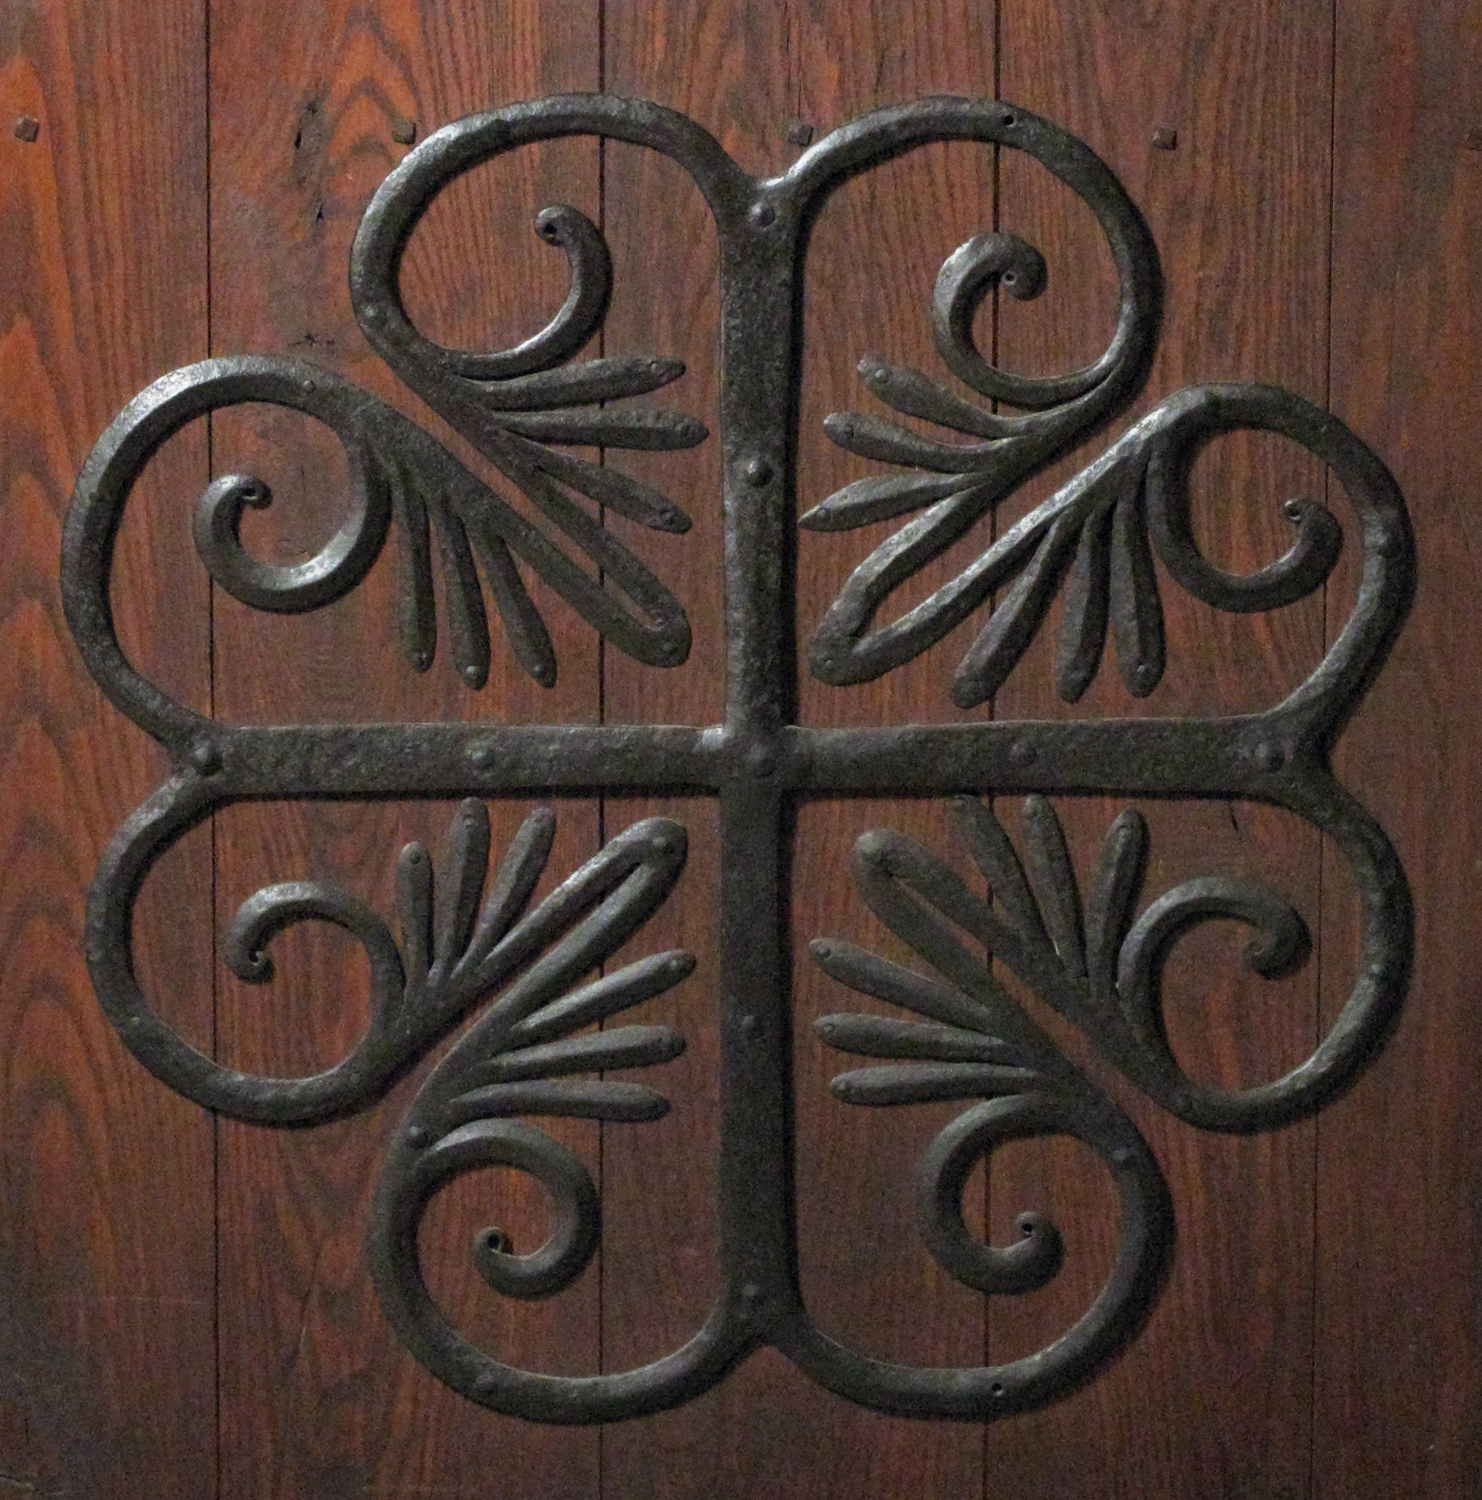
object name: door mount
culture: french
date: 1001-1100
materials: iron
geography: france